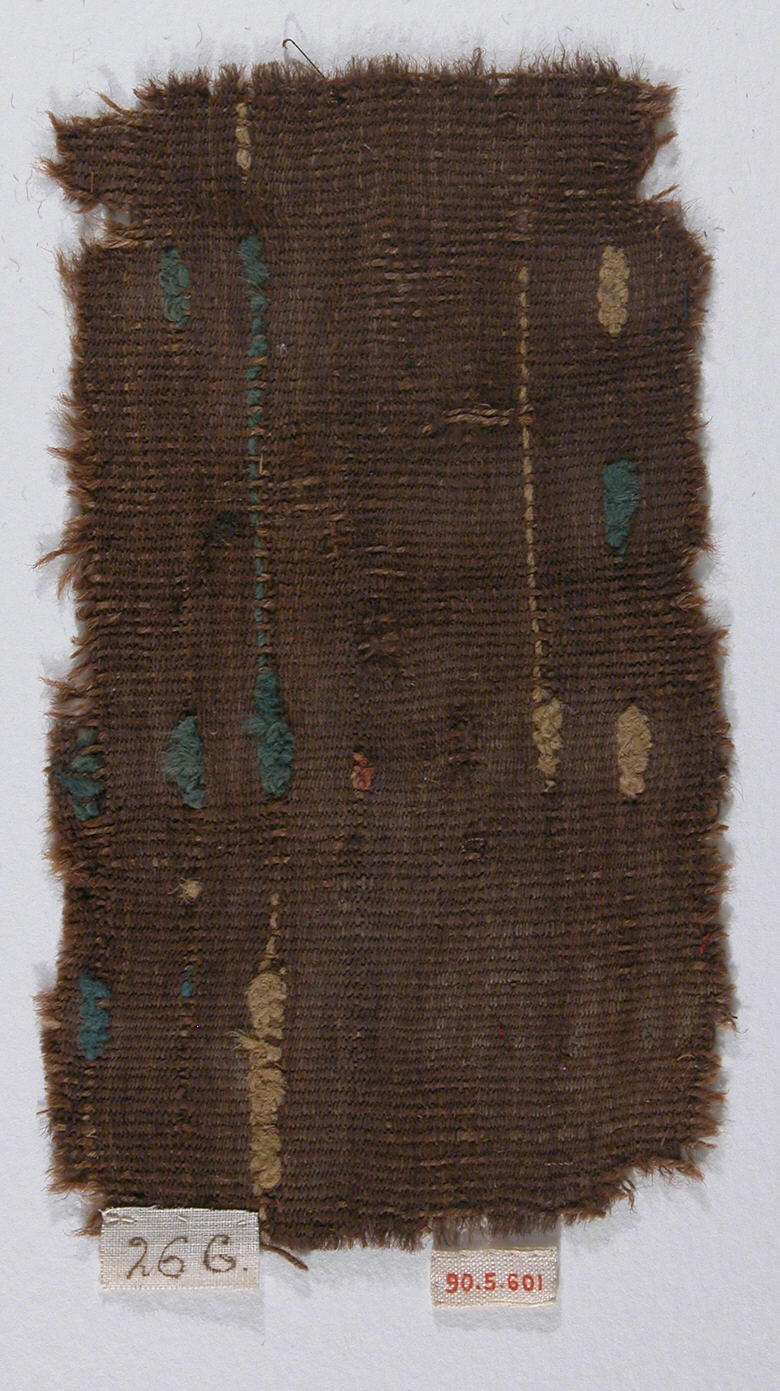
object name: textile fragment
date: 401-600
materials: wool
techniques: weave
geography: egypt